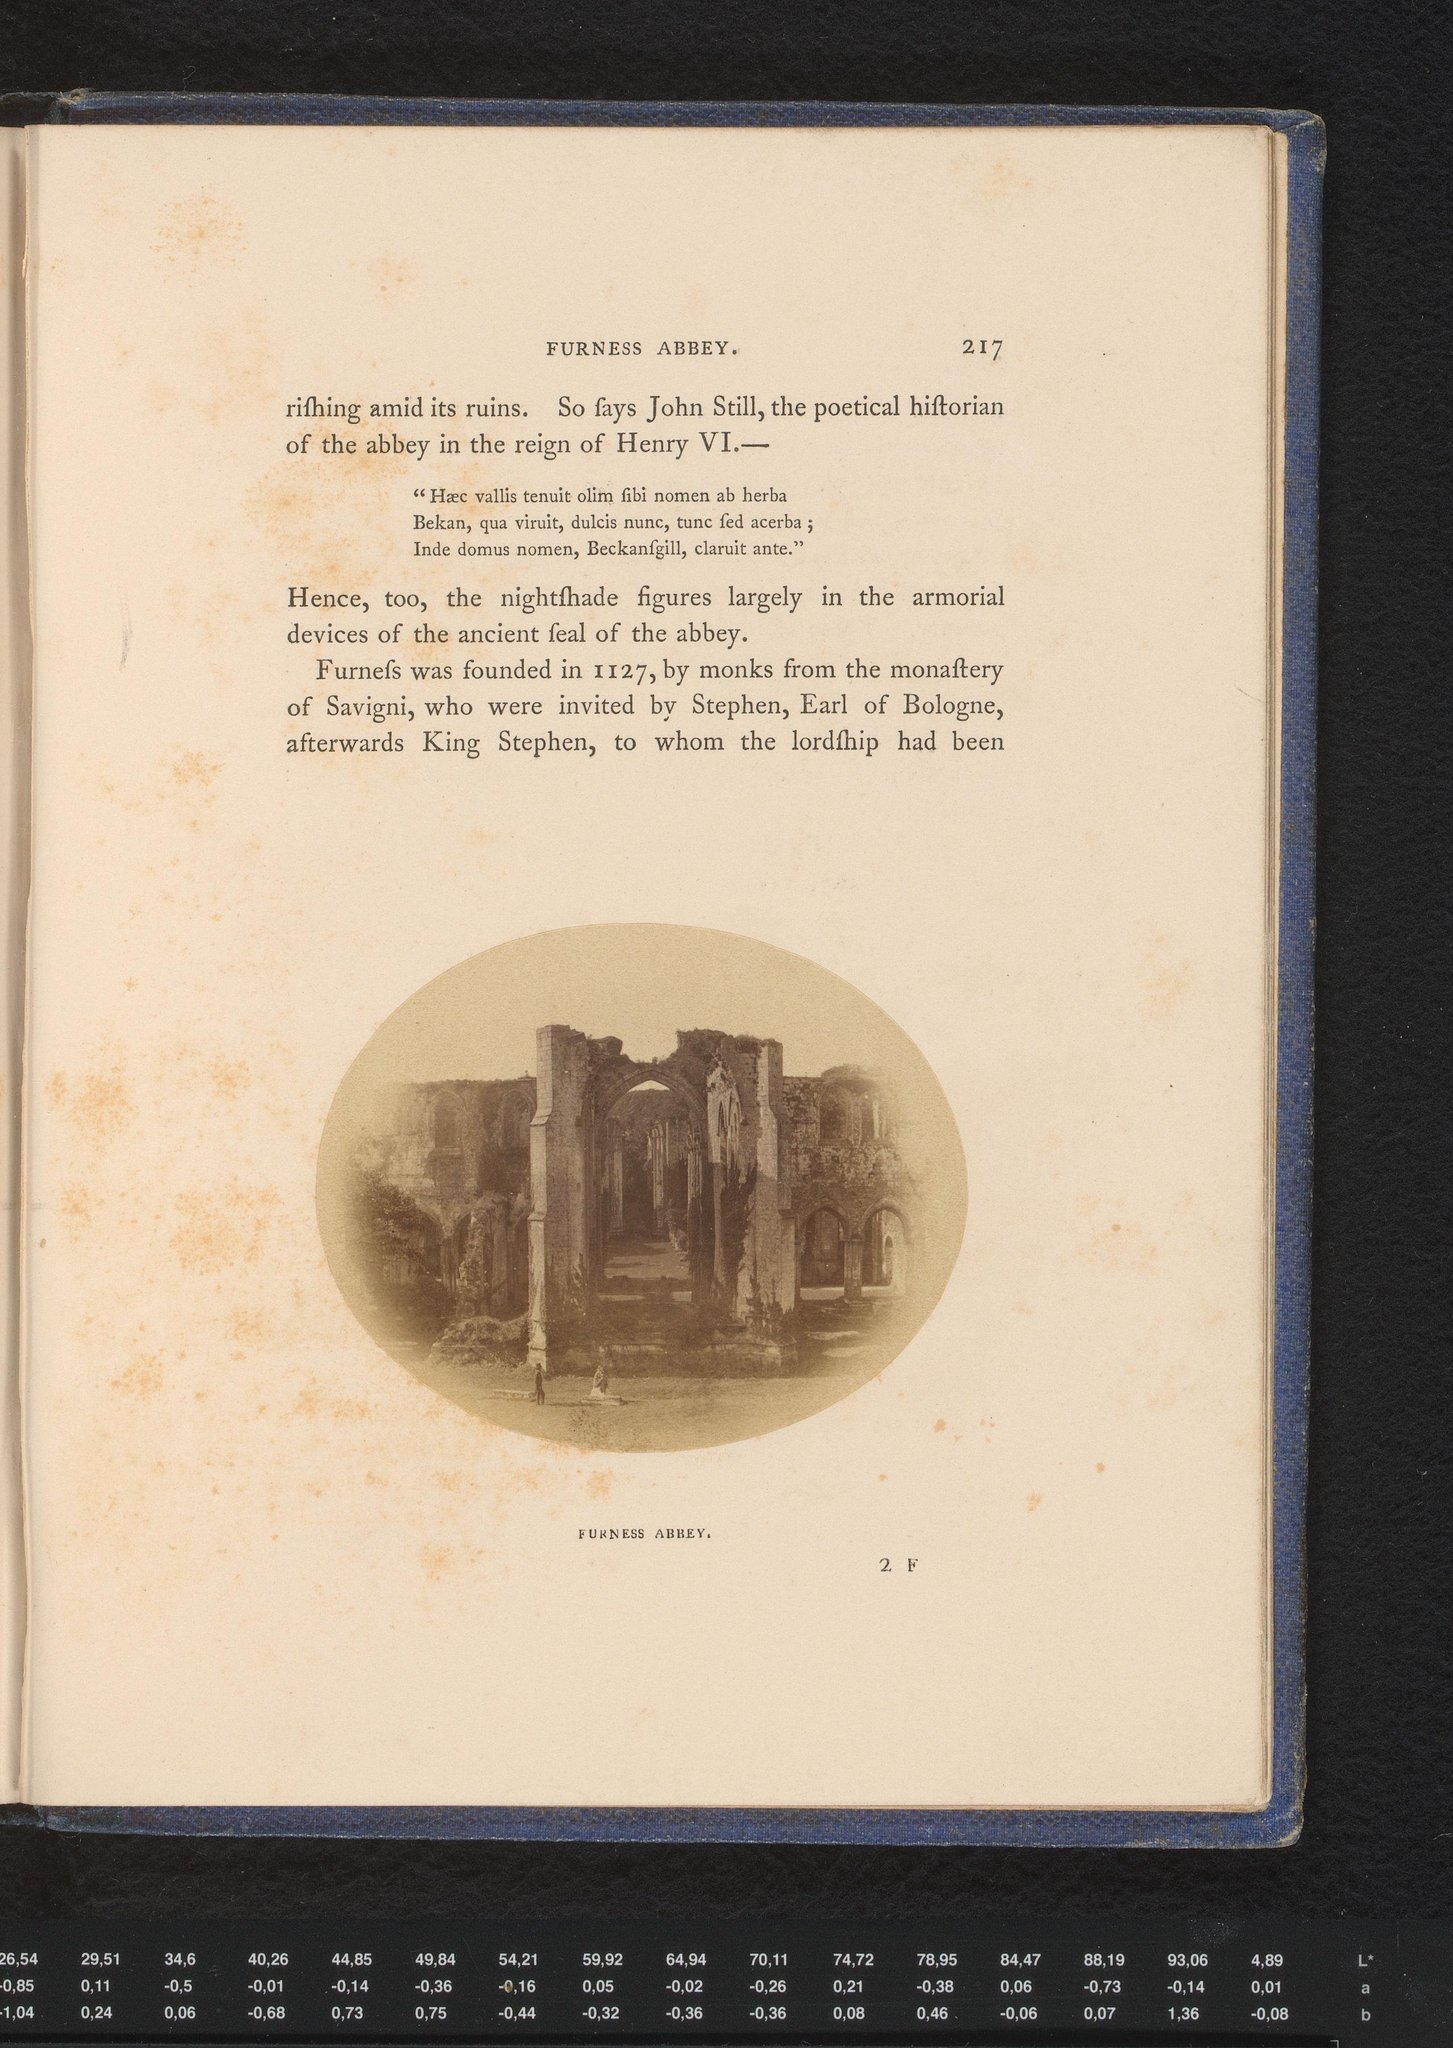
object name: photograph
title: Furness Abbey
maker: roger fenton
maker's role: fotograaf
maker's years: 1819-1869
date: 1857-1862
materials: paper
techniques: albumen print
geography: rievalx abbey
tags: ruin of church, monastery, etc., landscape with ruins (+ city(-scape) with figures, staffage)